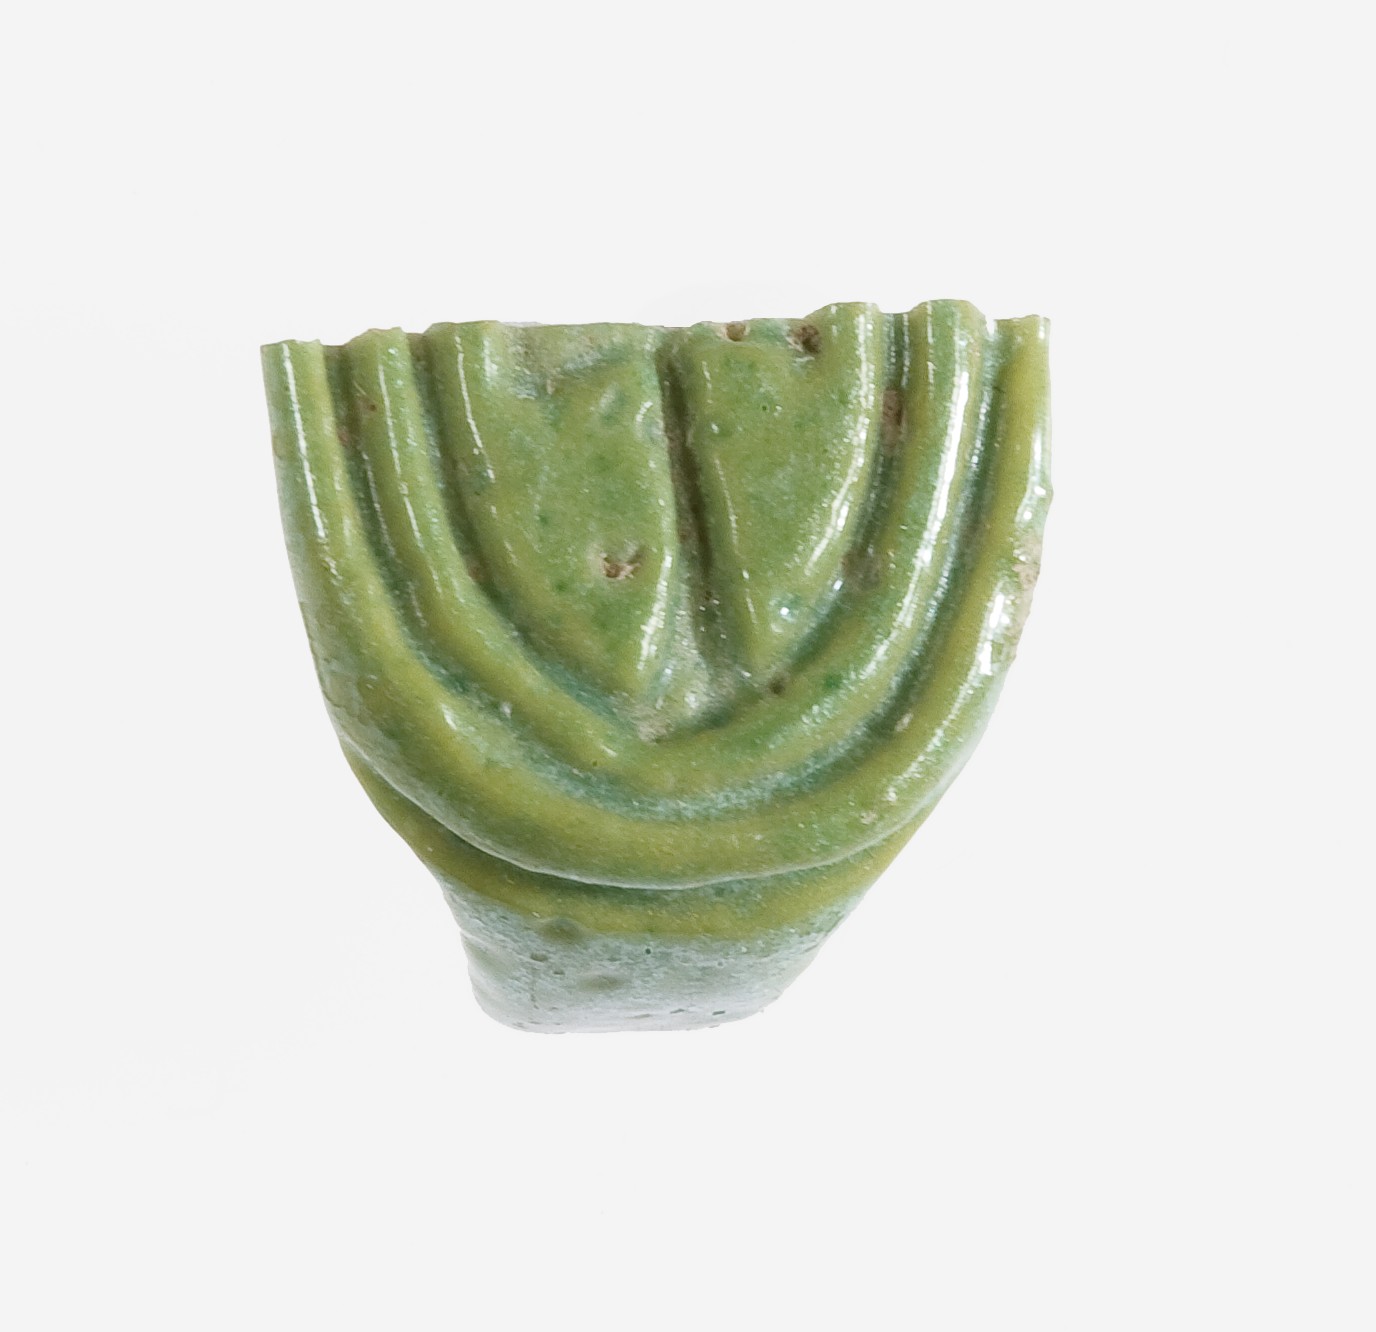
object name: ring fragment, ankh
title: Ring Fragment with ankh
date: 1390-1352 BCE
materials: faience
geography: egypt